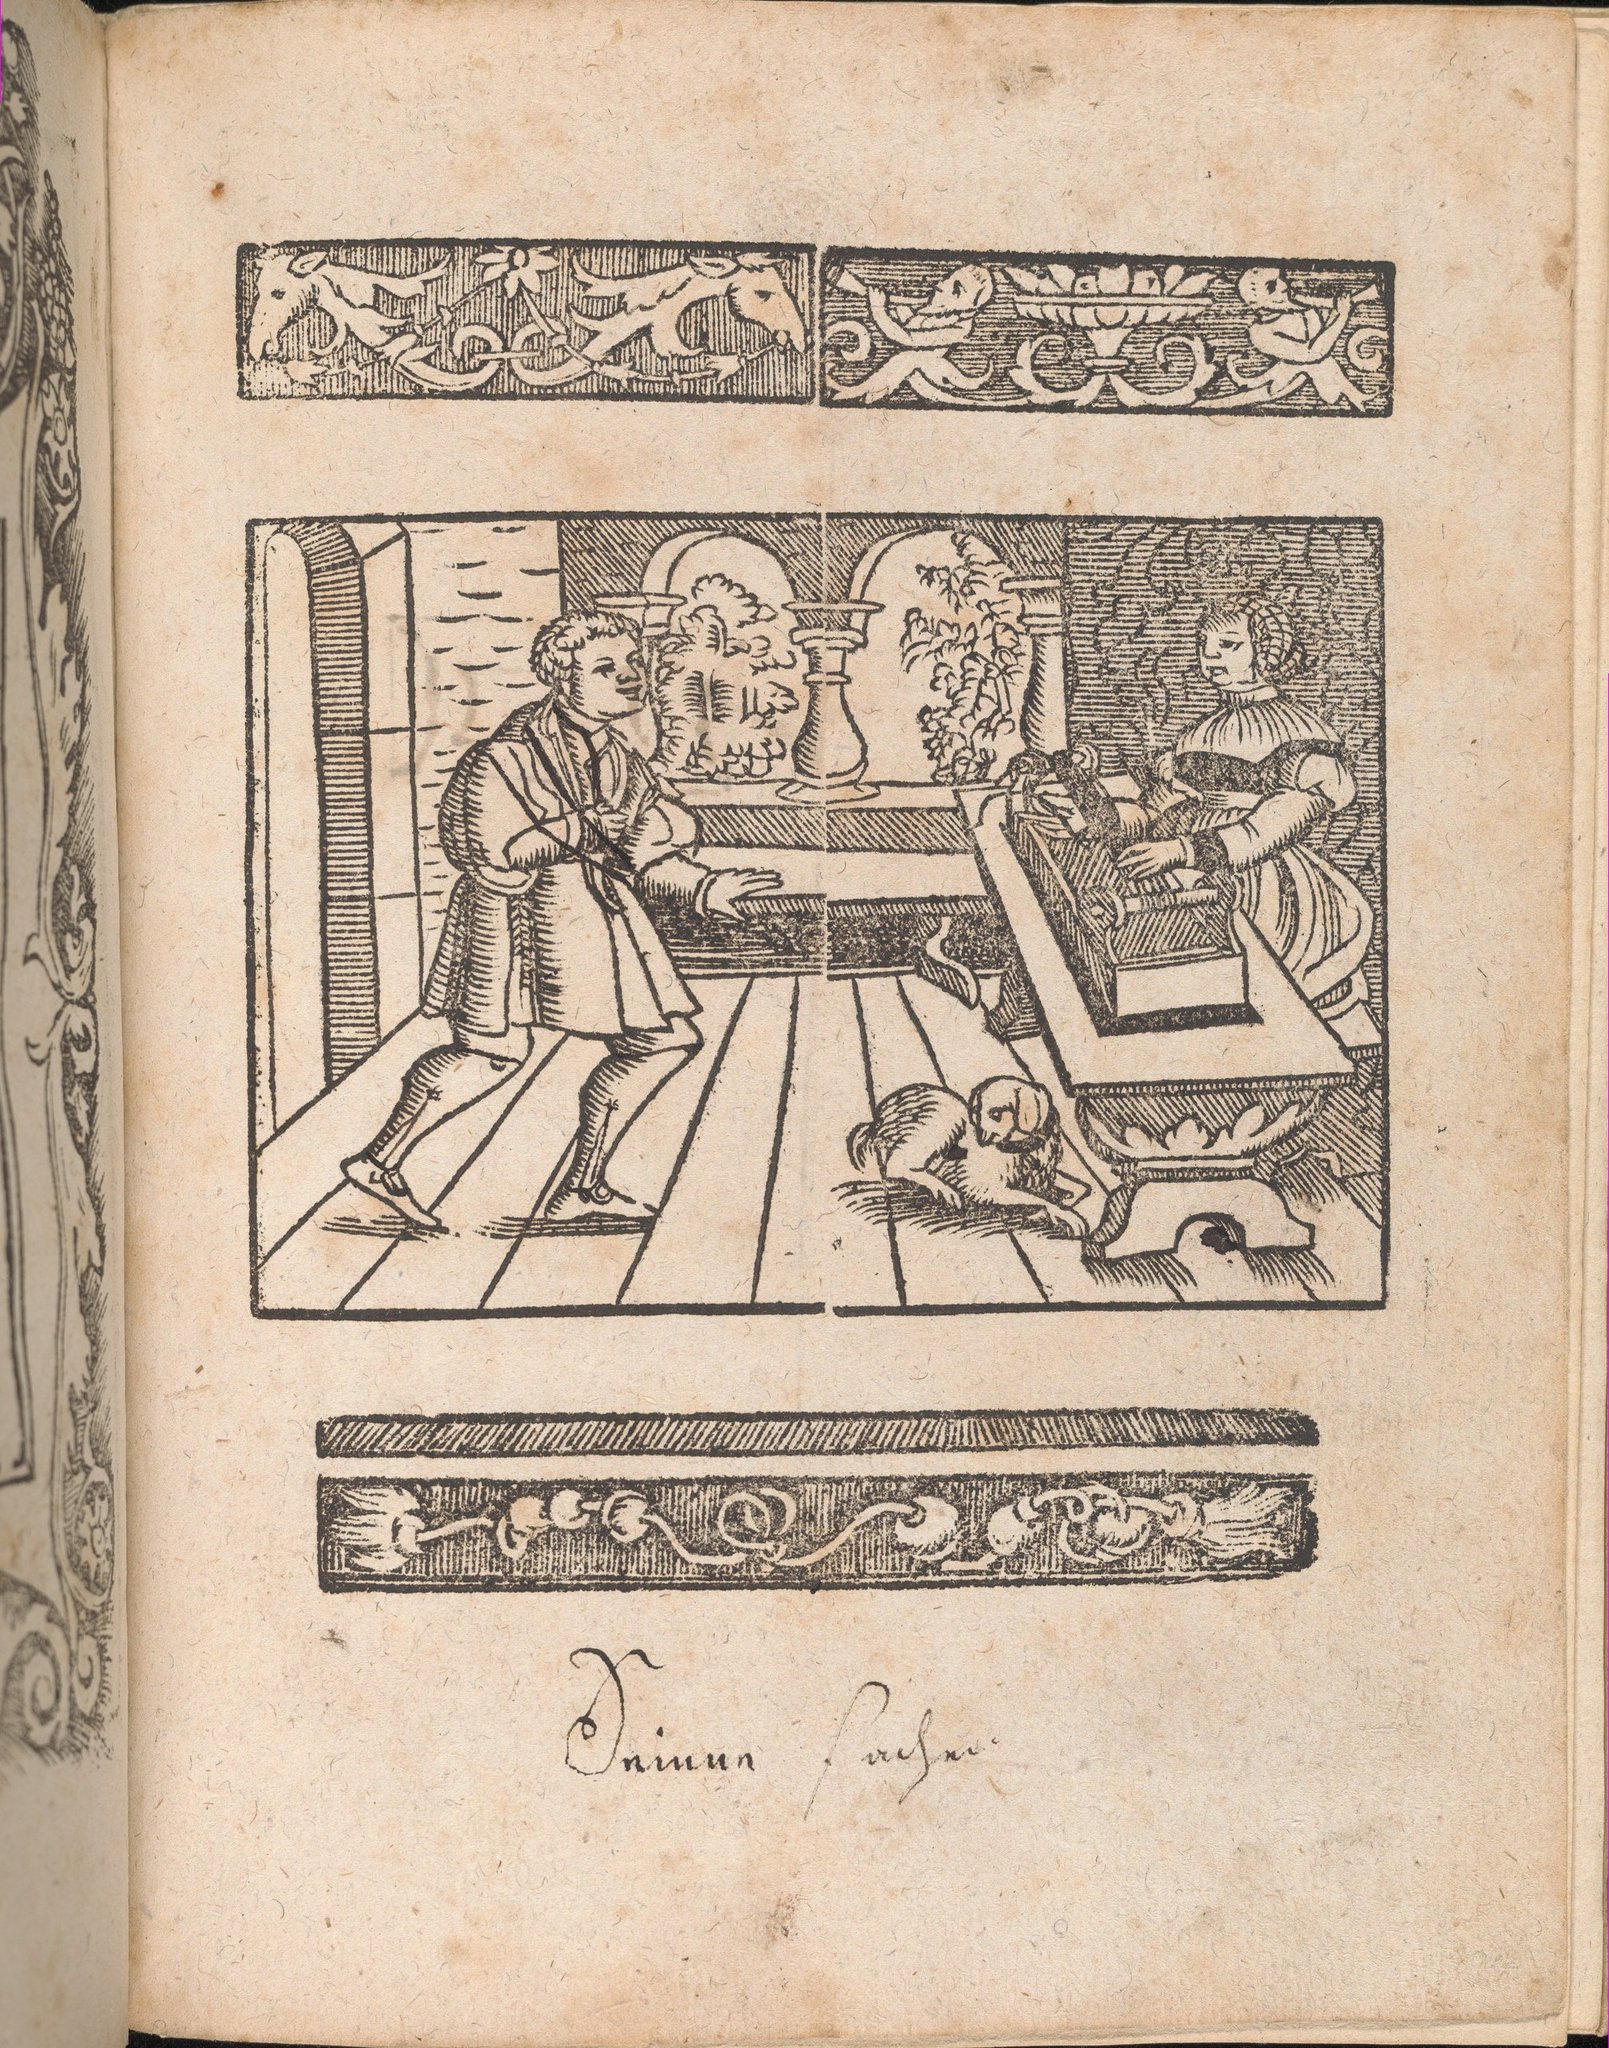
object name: book print ornament architecture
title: New Modelbüch allen Nägerin u. Sydenstickern (Page 28r)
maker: hans hoffman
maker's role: designer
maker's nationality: german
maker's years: 1556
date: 1556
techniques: woodcut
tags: books,men,women,working